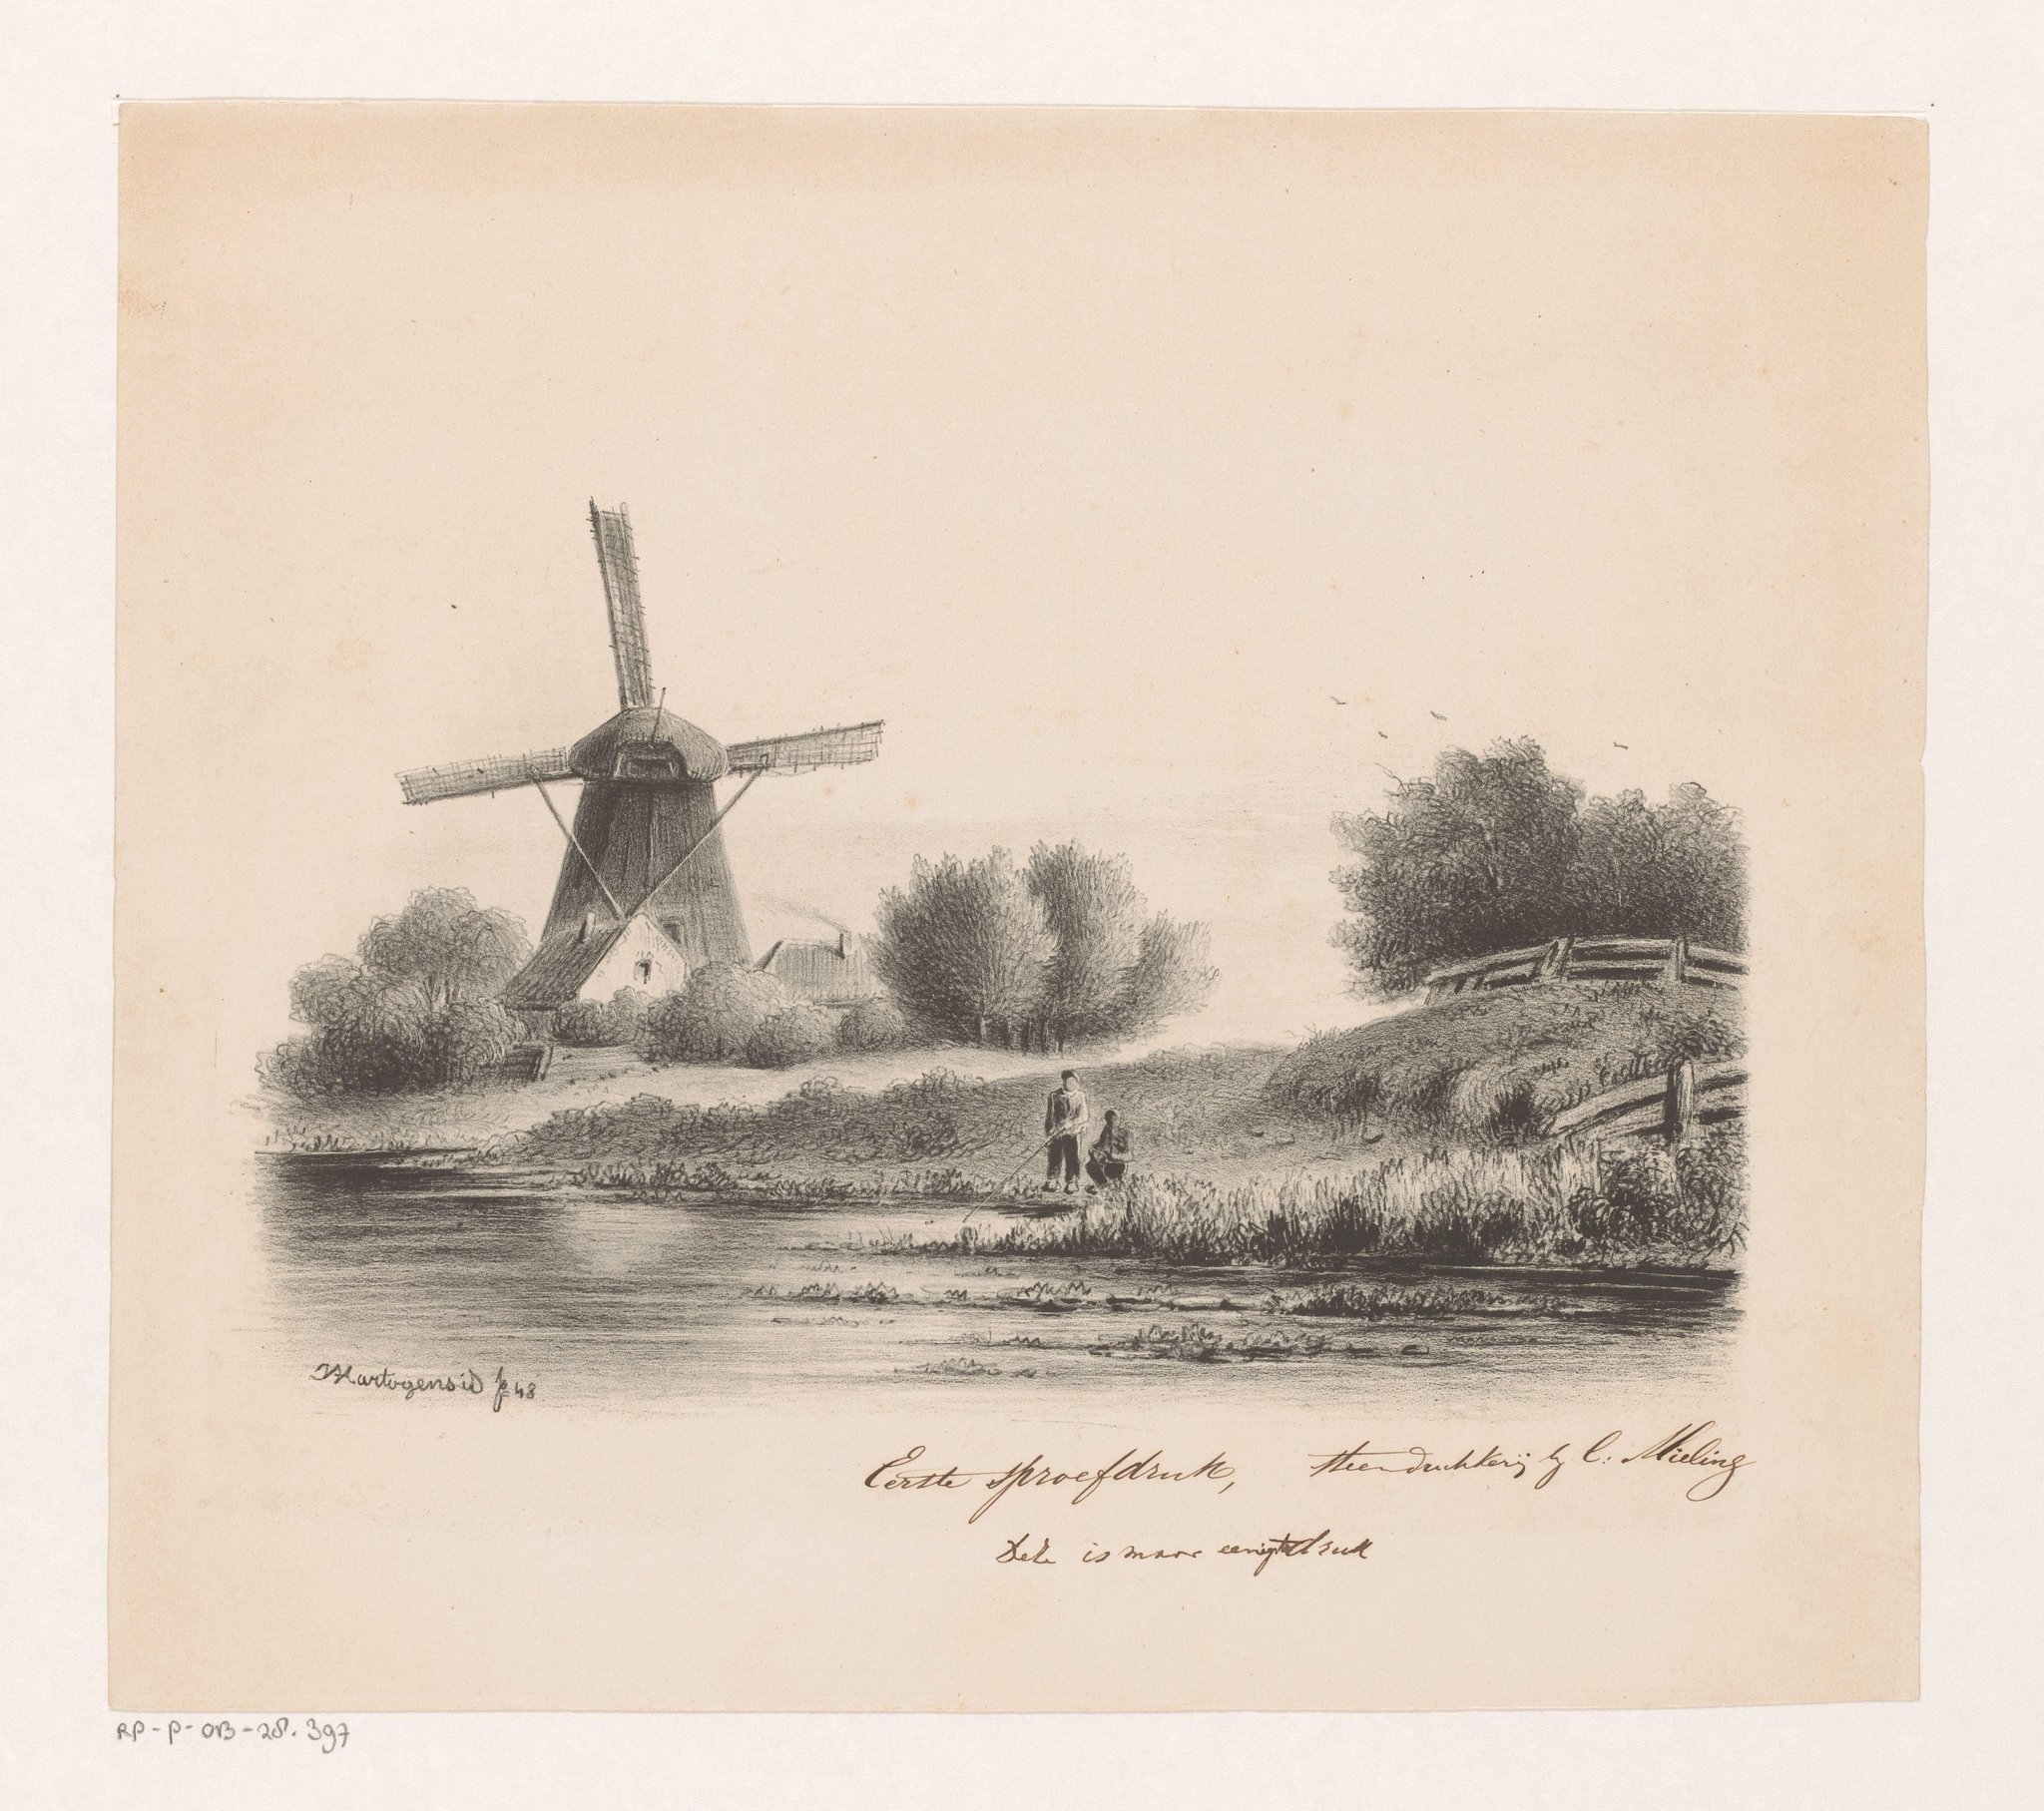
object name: print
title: Landschap met molen en twee vissers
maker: joseph hartogensis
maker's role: painter, print maker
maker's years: 1822-1865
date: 1848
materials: paper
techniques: lithograph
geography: the hague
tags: windmill, river (+ landscape with figures, staffage), fisherman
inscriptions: inscription: ‘Eerste proefdruk, steendrukkerij G L. Mieling / Deze is maar enigste druk’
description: De vissers staan op de oever van een rivier.